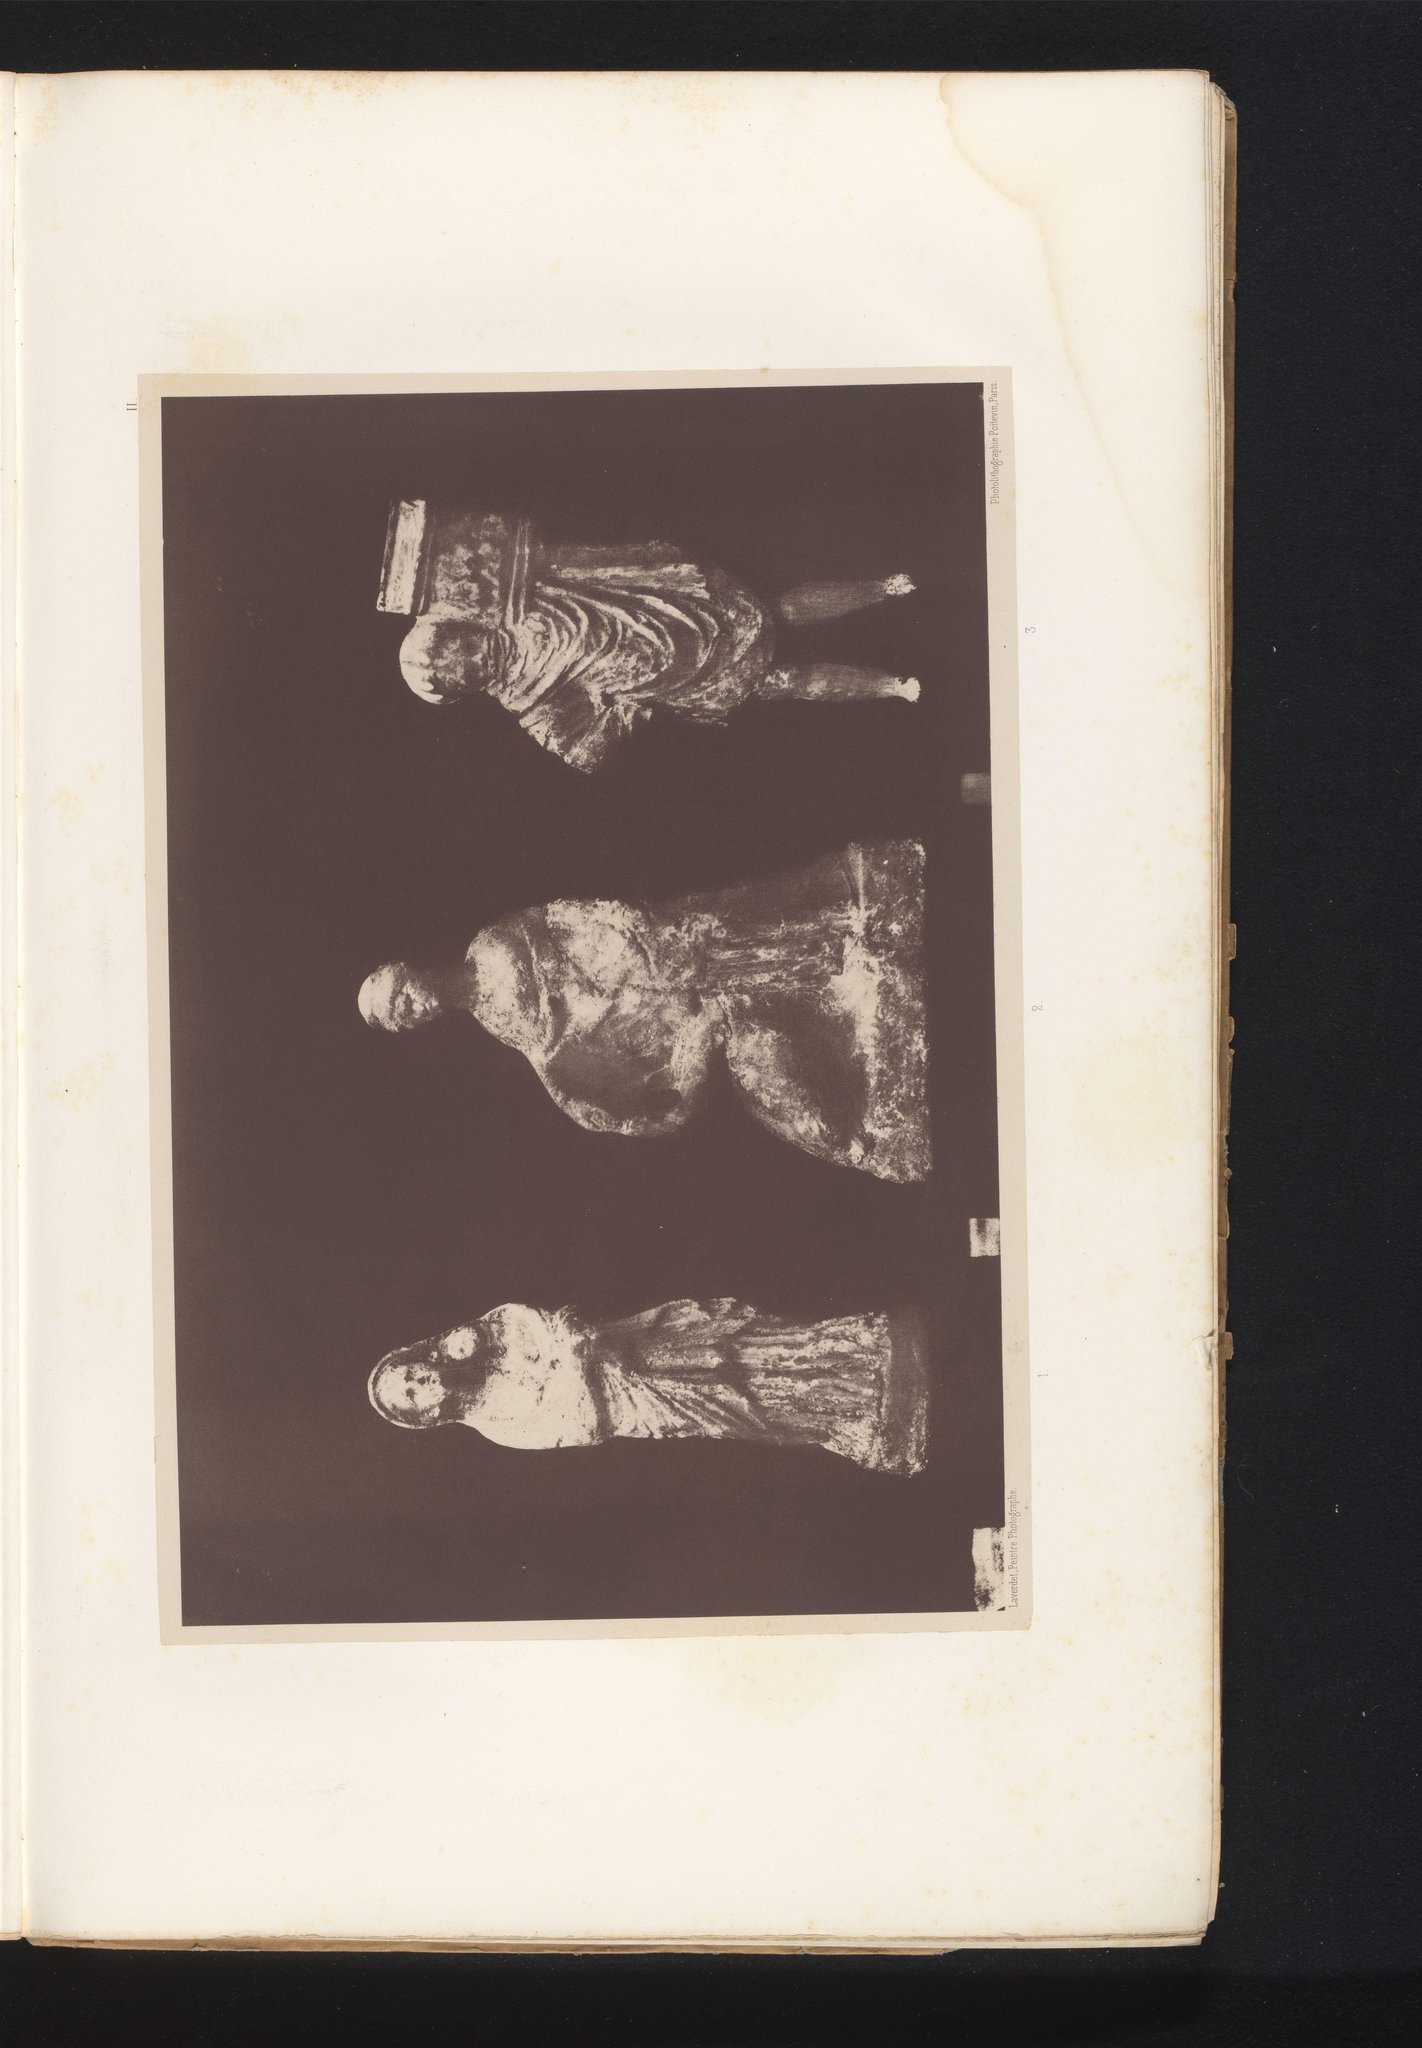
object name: page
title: Drie terracotta sculpturen van een moeder met kind, Leda of Penelope die een zwaan voert en een acteur in gedrapeerd gewaad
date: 1852-1857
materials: paper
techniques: photolithography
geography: paris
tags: piece of sculpture, reproduction of a piece of sculpture (+ clay, sand, etc. ~ arts), mother and baby or young child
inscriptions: number: ‘II.’, number: ‘1. 2. 3.’